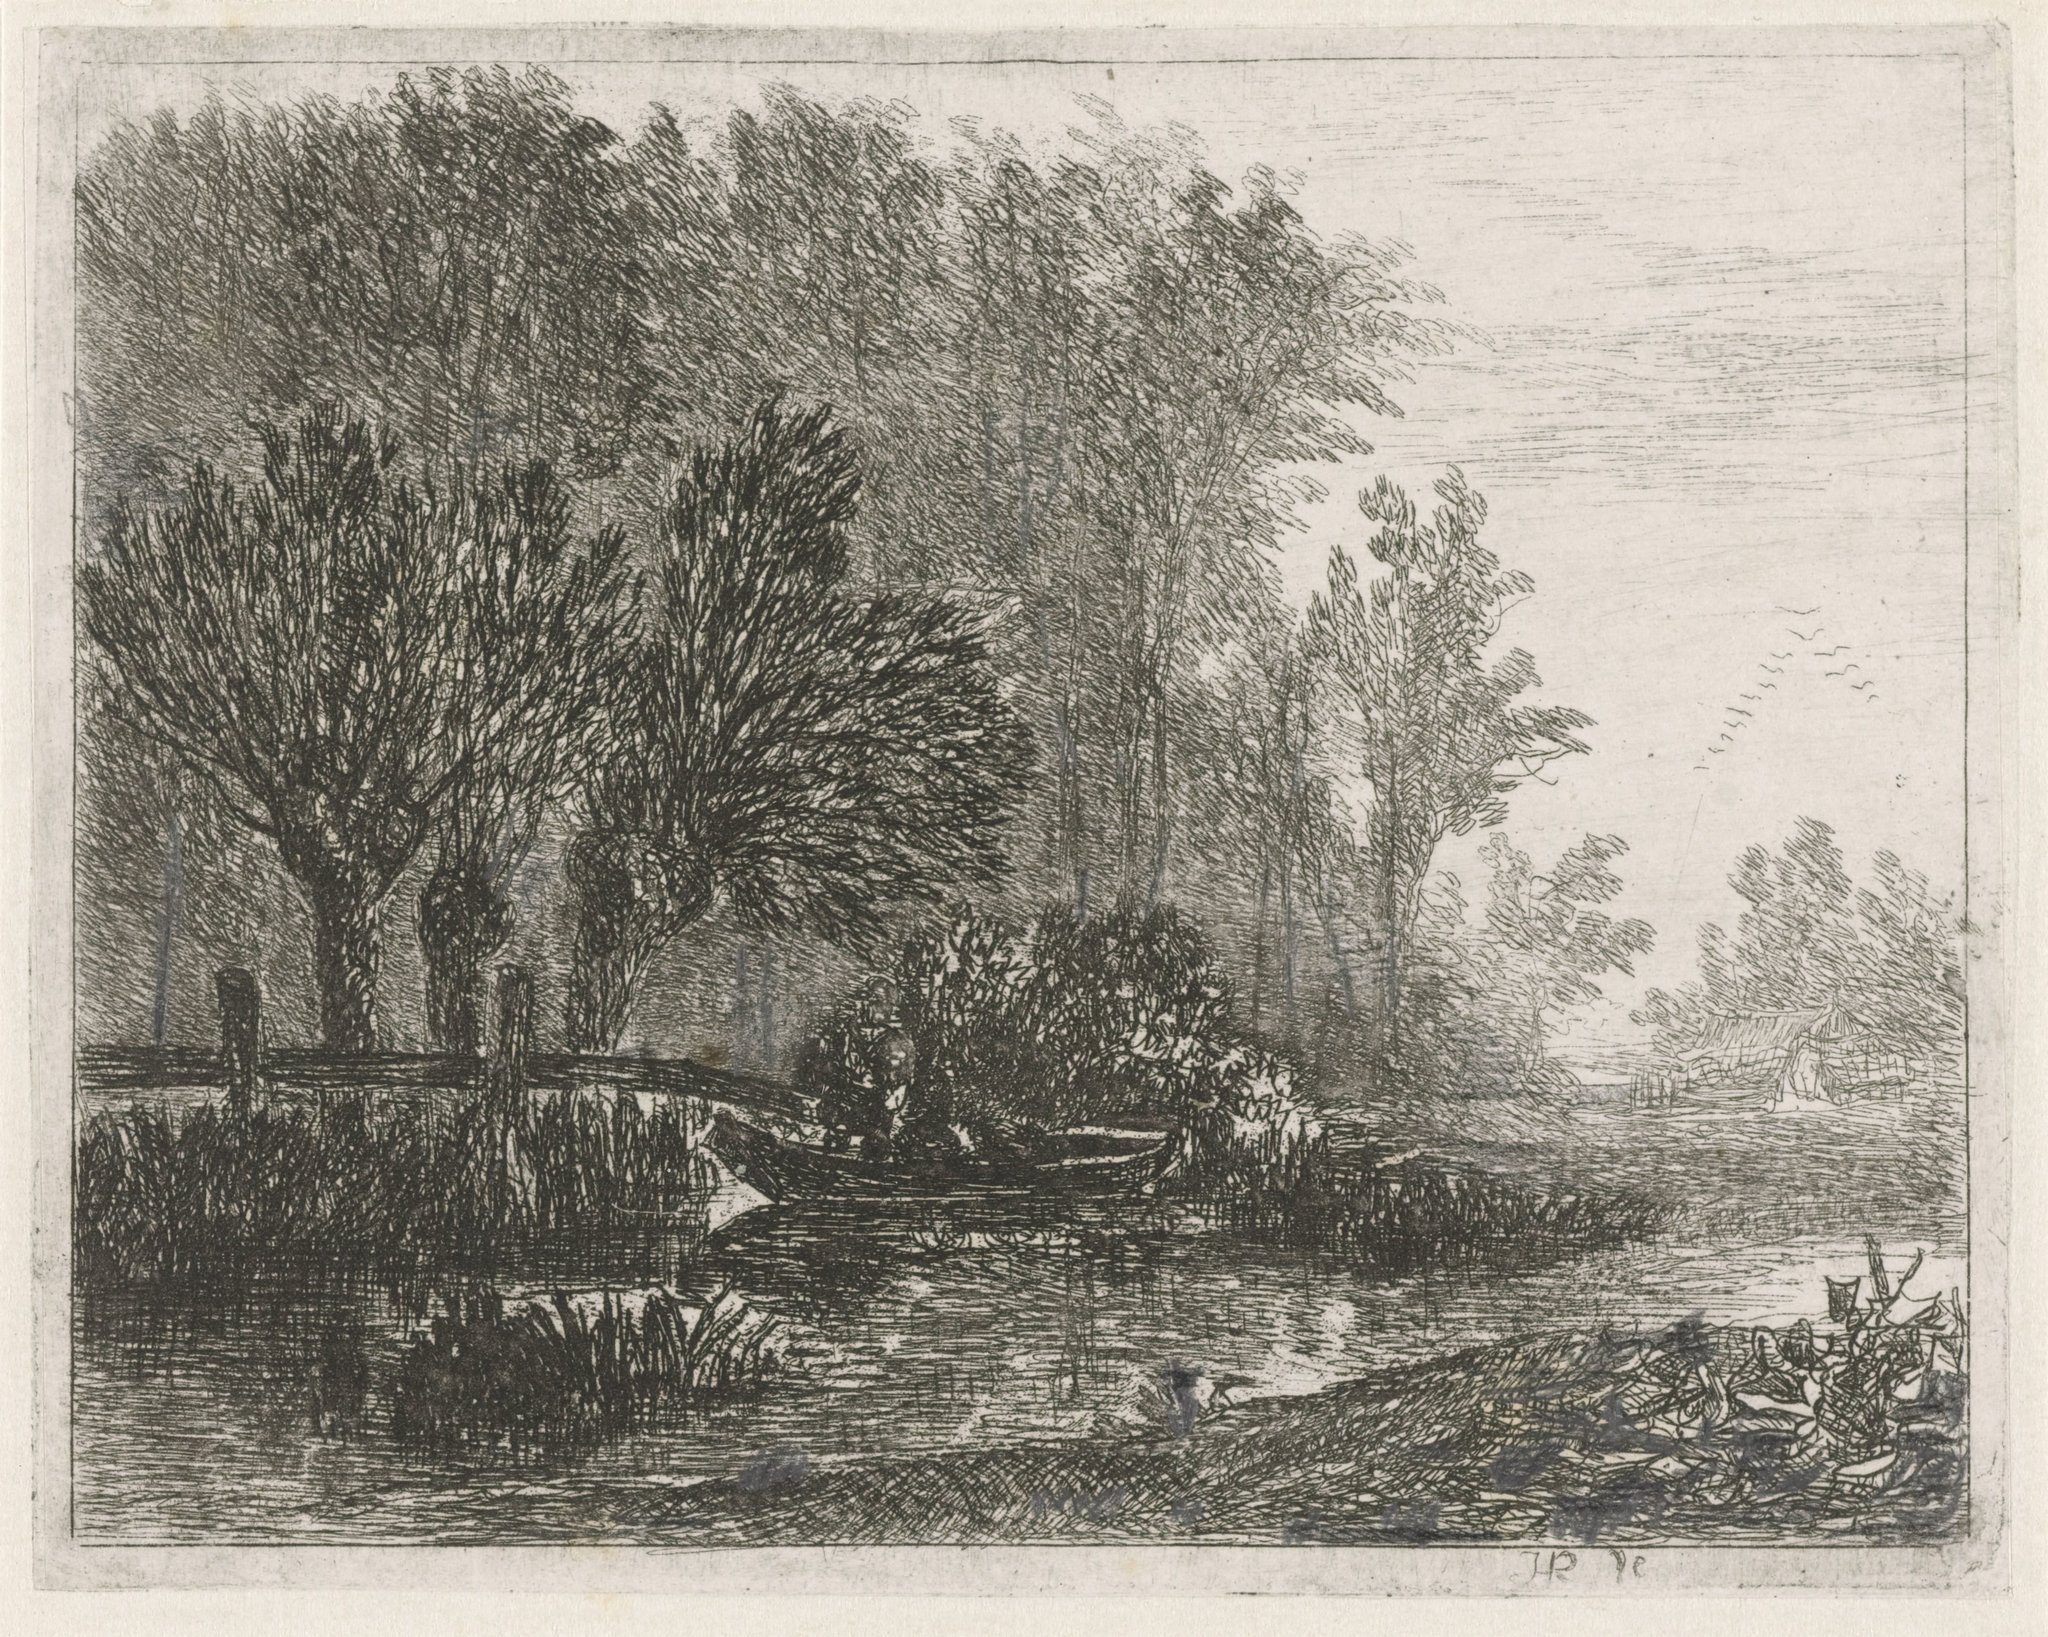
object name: print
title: Visser in een boot aan de bosrand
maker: hermanus jan hendrik van rijkelijkhuysen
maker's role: painter, print maker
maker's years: 1813-1883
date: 1823-1883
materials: paper, pencil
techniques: etching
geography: utrecht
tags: river, forest, wood, hut, cabin, lodge, fisherman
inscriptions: collector's mark: Lugt 2228, collector's mark: Lugt 1485